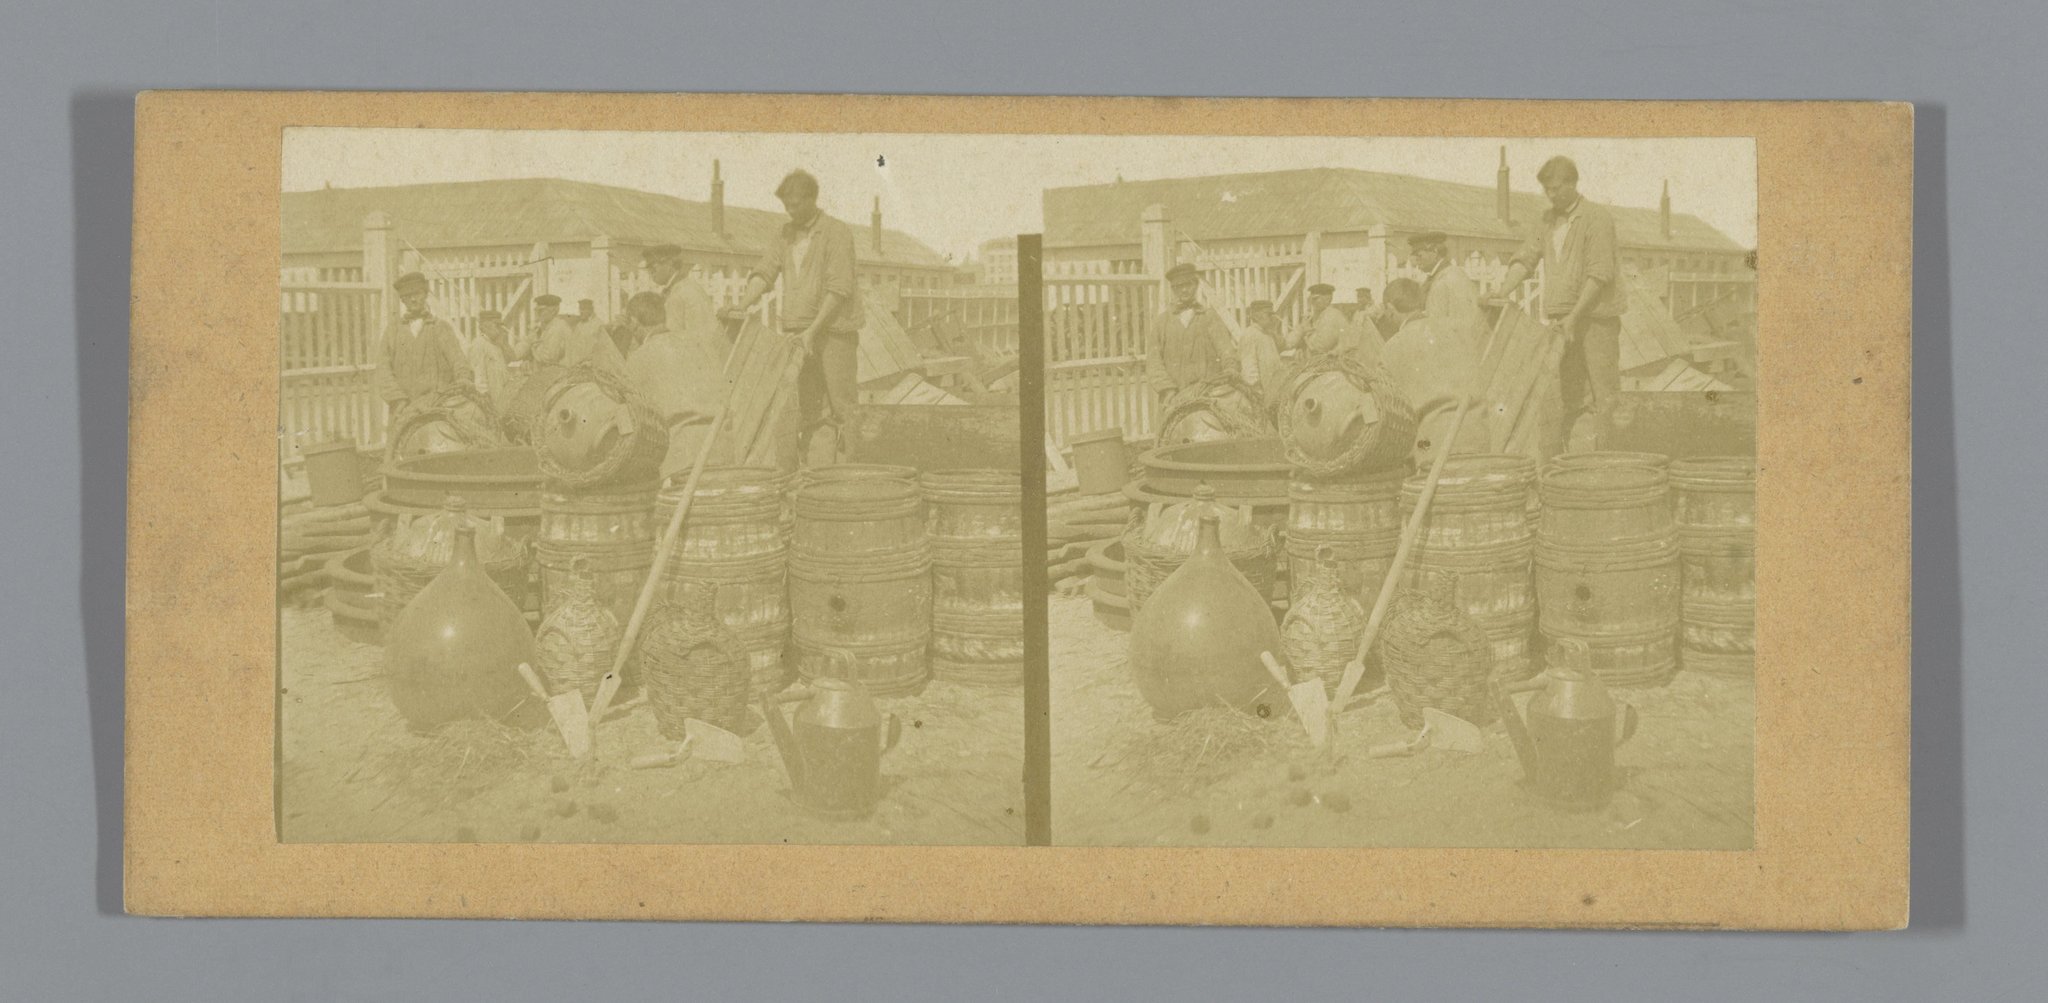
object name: stereograph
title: Mannen tussen vaten en mandflessen (vermoedelijk) te Frankrijk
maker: Anonymous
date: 1855-1865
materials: cardboard, photographic support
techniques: albumen print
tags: wooden container: barrel, cask, bucket, adult man